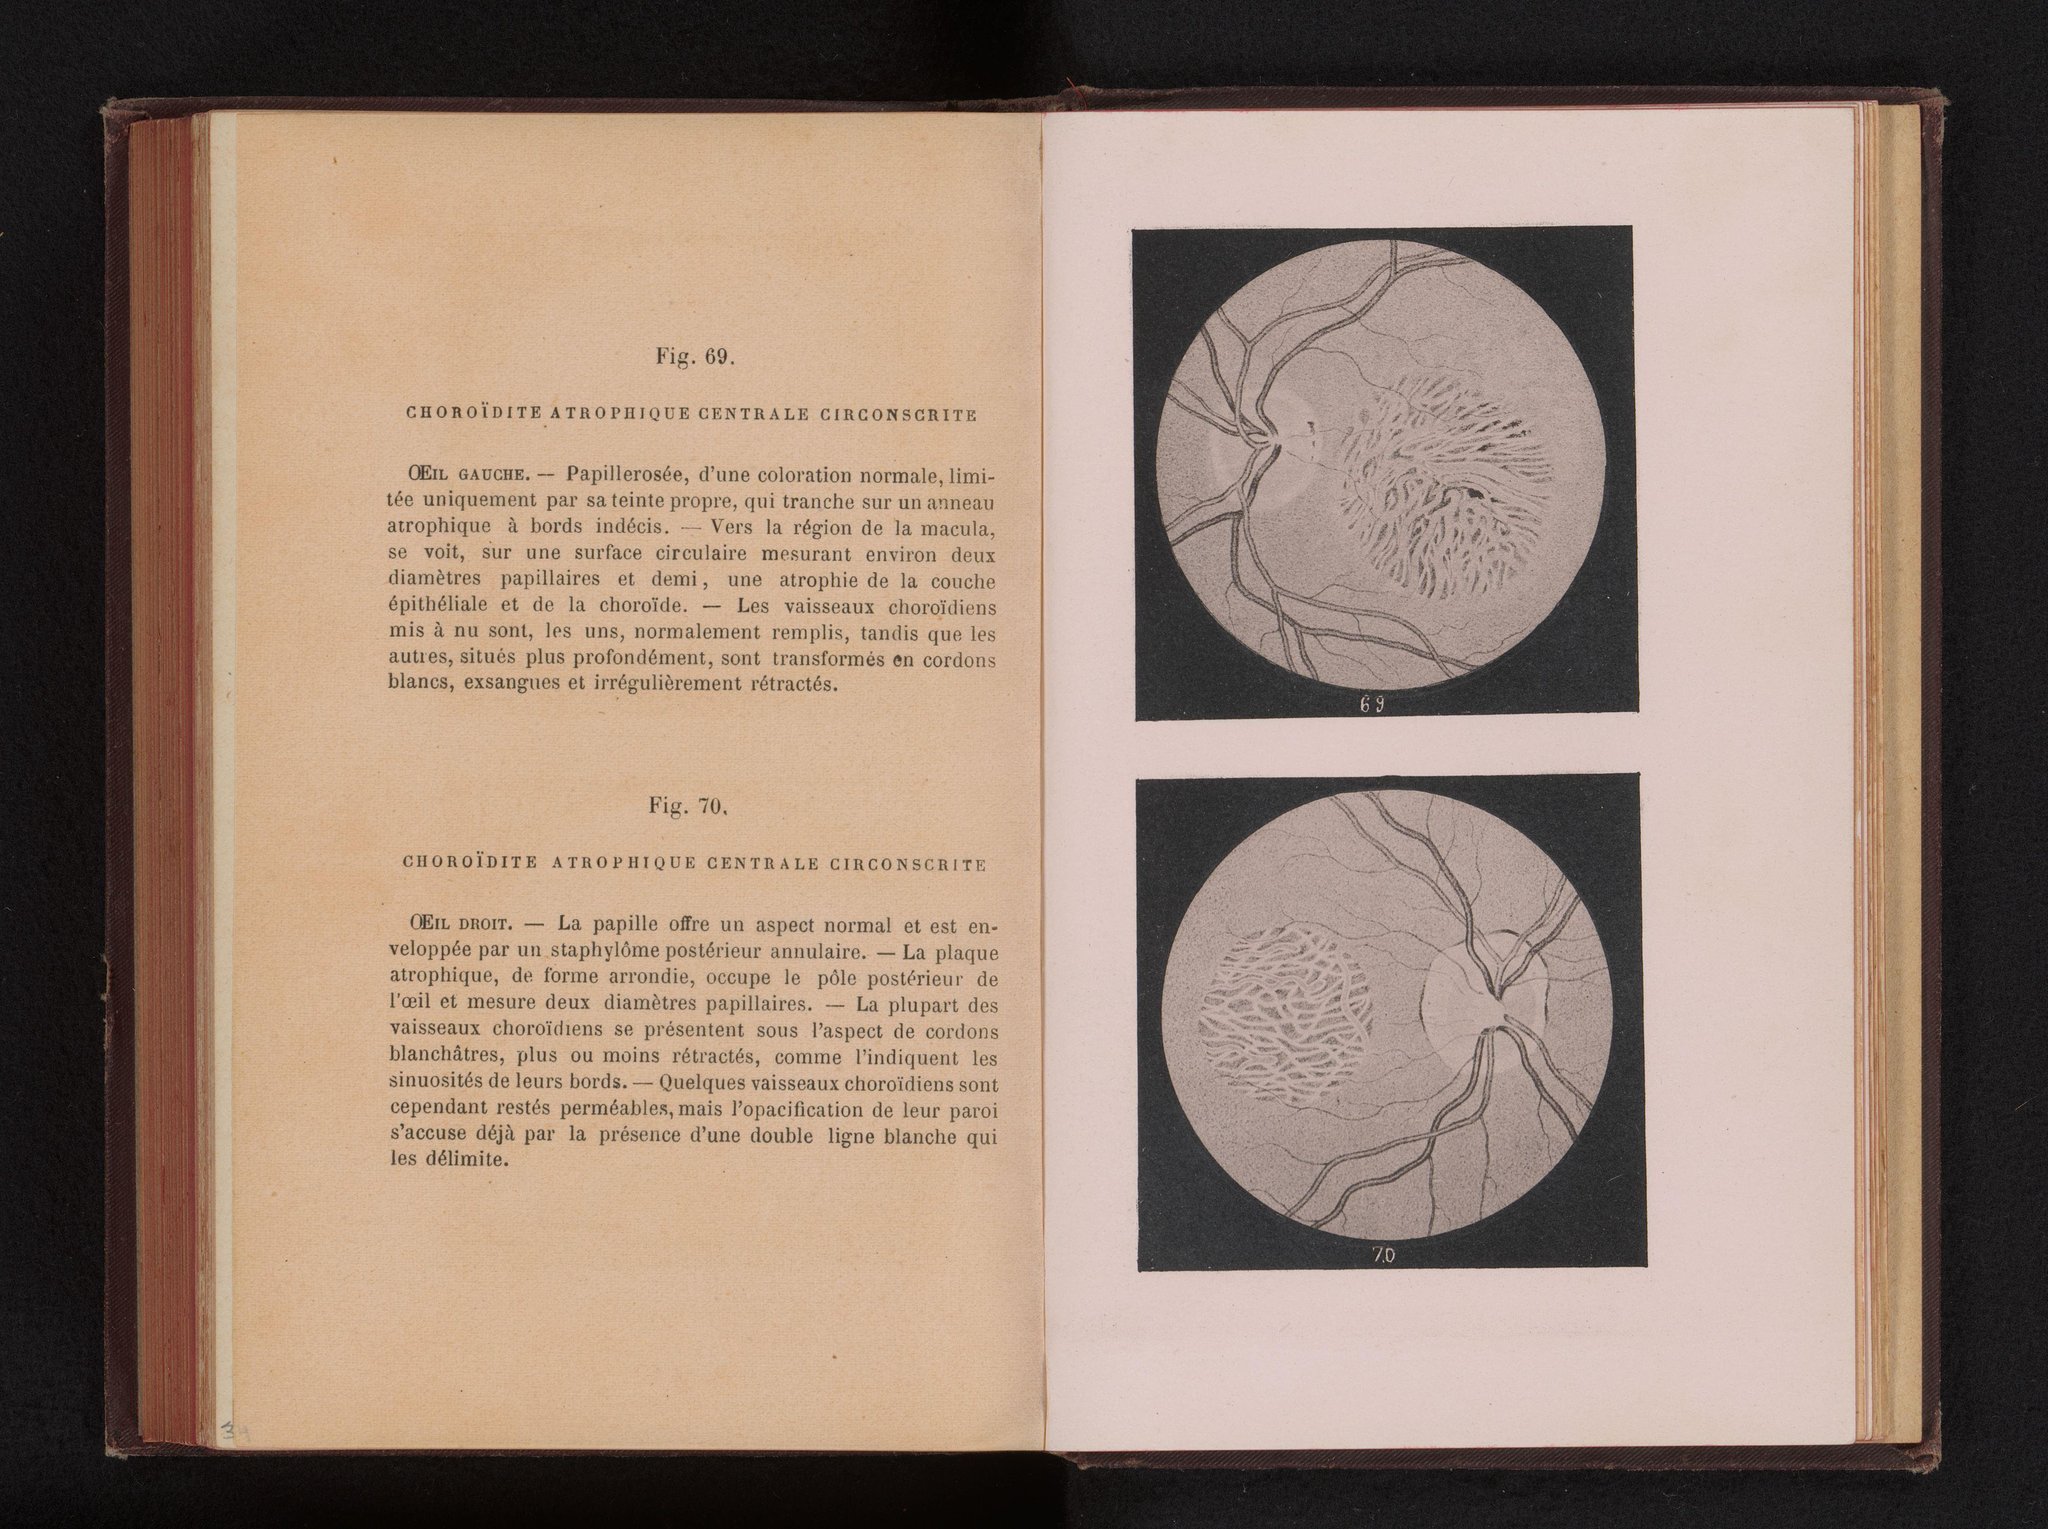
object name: reproduction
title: Fotoreproductie van twee anatomische tekeningen van een ontsteking aan het vaatvlies in een oog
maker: Anonymous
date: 1871-1891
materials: paper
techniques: photograph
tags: anatomy (non-medical), eyes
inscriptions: inscription: ‘Fig. 69. Choroïdite atrophique centrale circonscrite Fig. 70. Choroïdite atrophique centrale circonscrite’